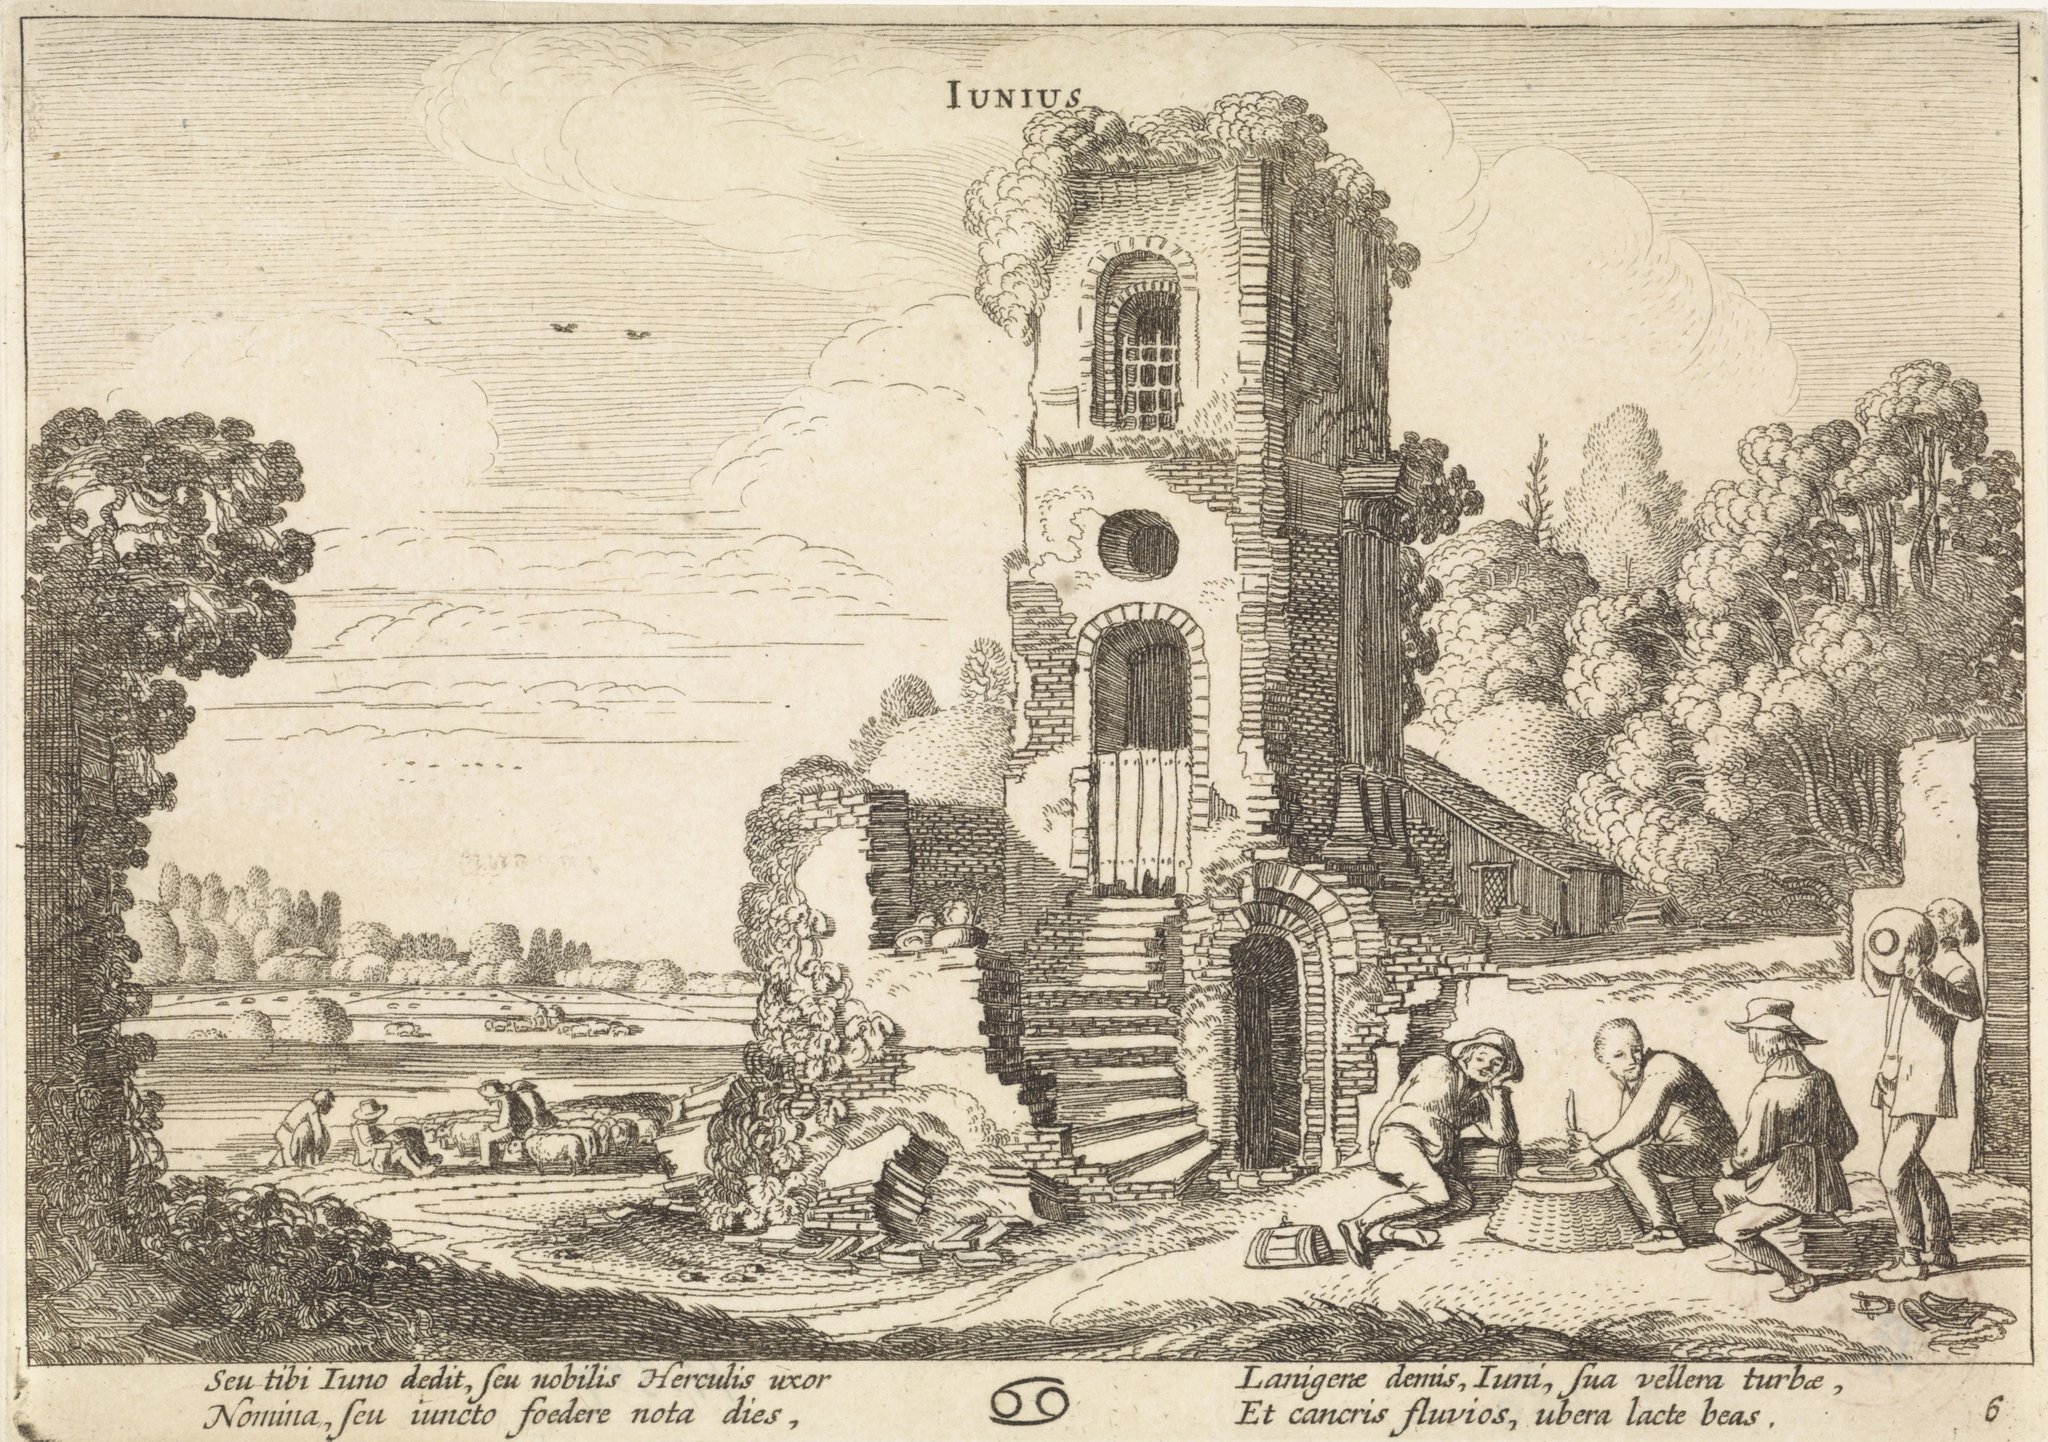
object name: print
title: Landschap met een vervallen toren: juni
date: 1608-1618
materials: paper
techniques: etching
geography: northern netherlands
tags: cancer (zodiacal sign of june), landscape symbolizing june, landscape with ruins, shearing (sheep)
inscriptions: collector's mark: Lugt 240, collector's mark: Lugt 698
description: Gezicht op een vervallen toren in een landschap, waarvoor vier rustende figuren, voorstellende de maand juni. Links herders bij hun kudde. Onderaan het astrologische symbool van het sterrenbeeld kreeft. Prent uit een serie van twaalf.